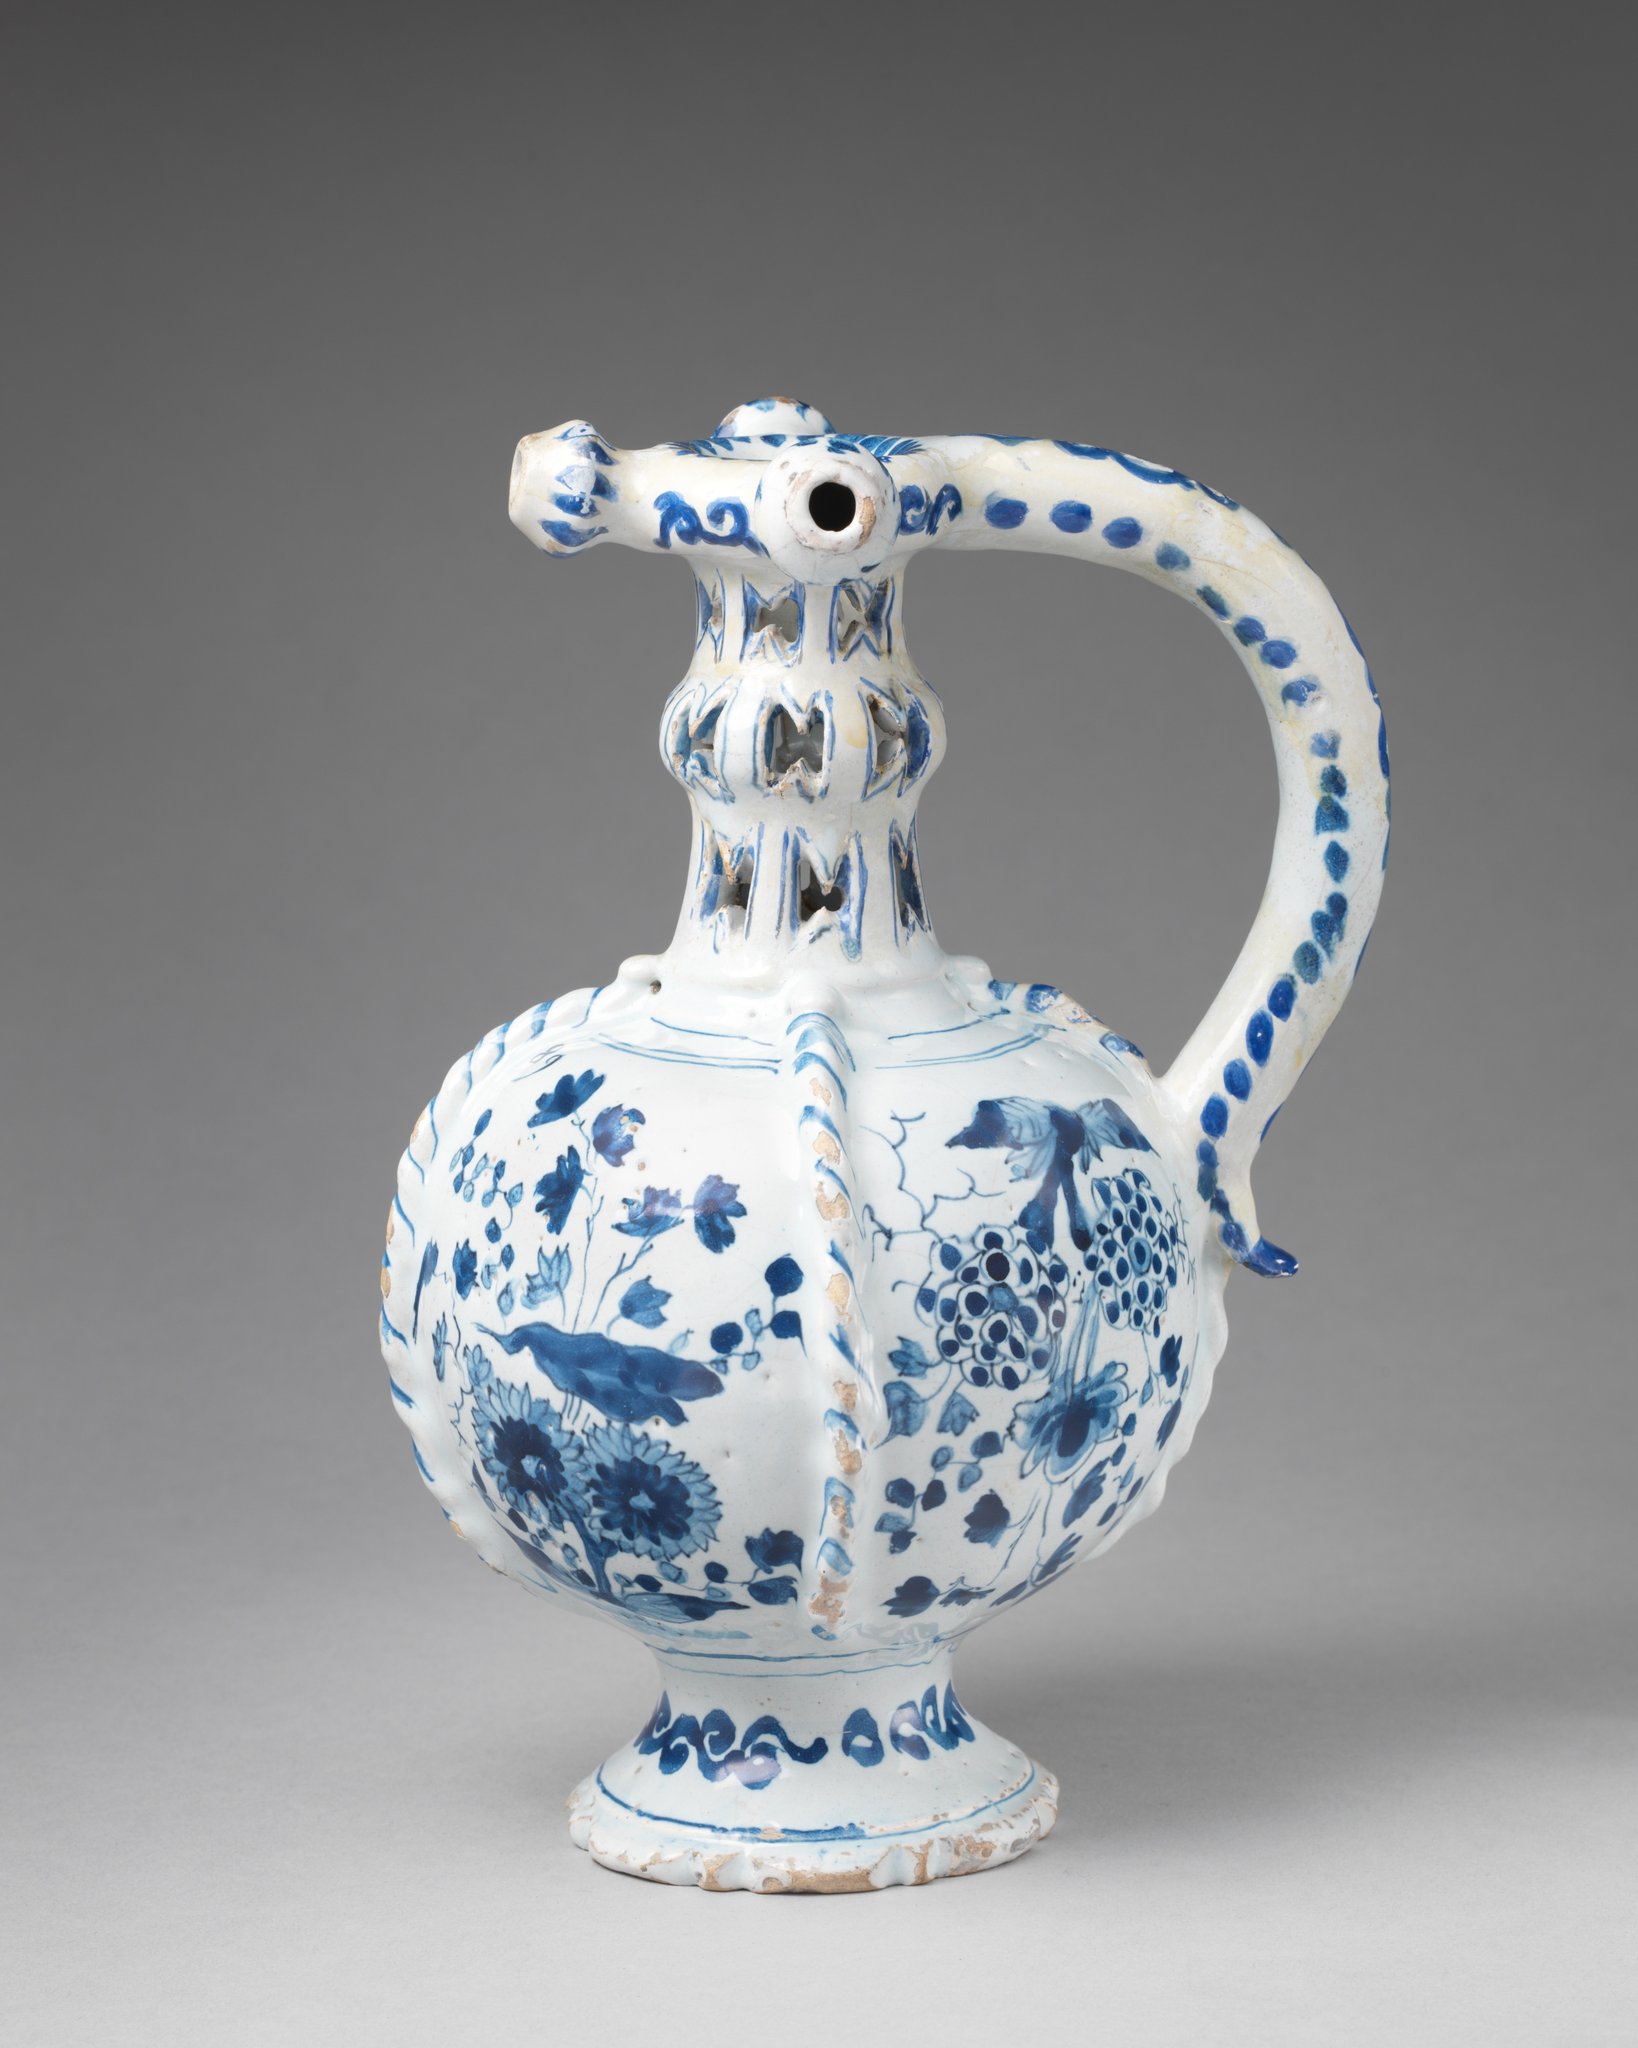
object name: puzzle jug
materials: earthenware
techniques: glazing